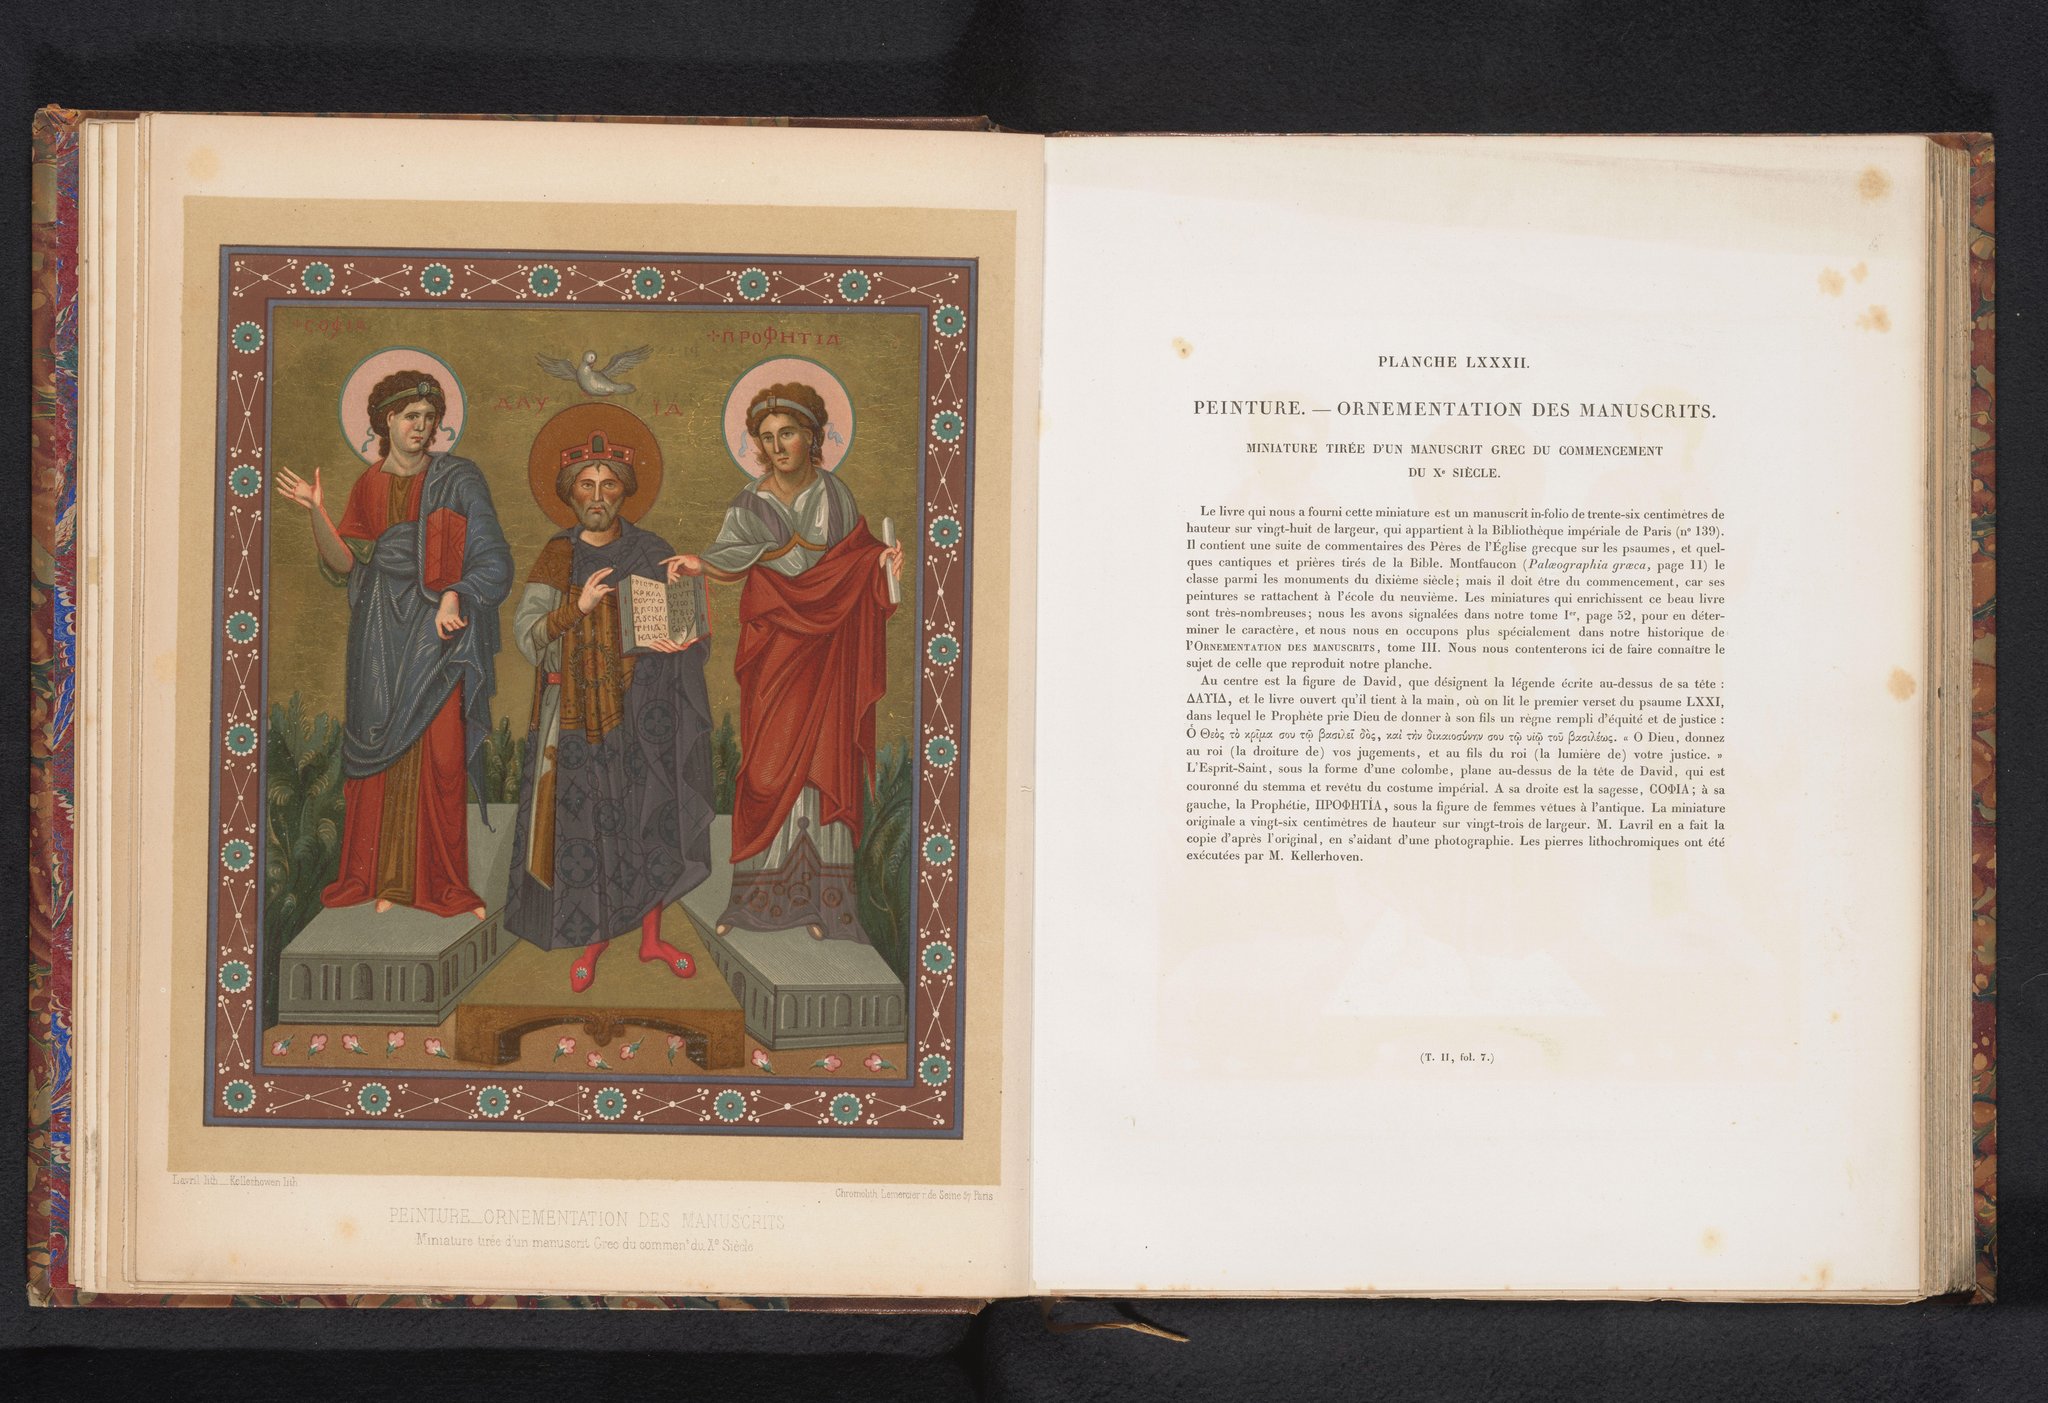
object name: page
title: Reproductie van een verluchte pagina met een voorstelling uit het verhaal van David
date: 1859-1864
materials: paper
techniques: chromolithography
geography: paris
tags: story of david, painting (including book-illumination, miniature-painting)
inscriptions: name: ‘Lavril del./ Kellerhowen Lith’